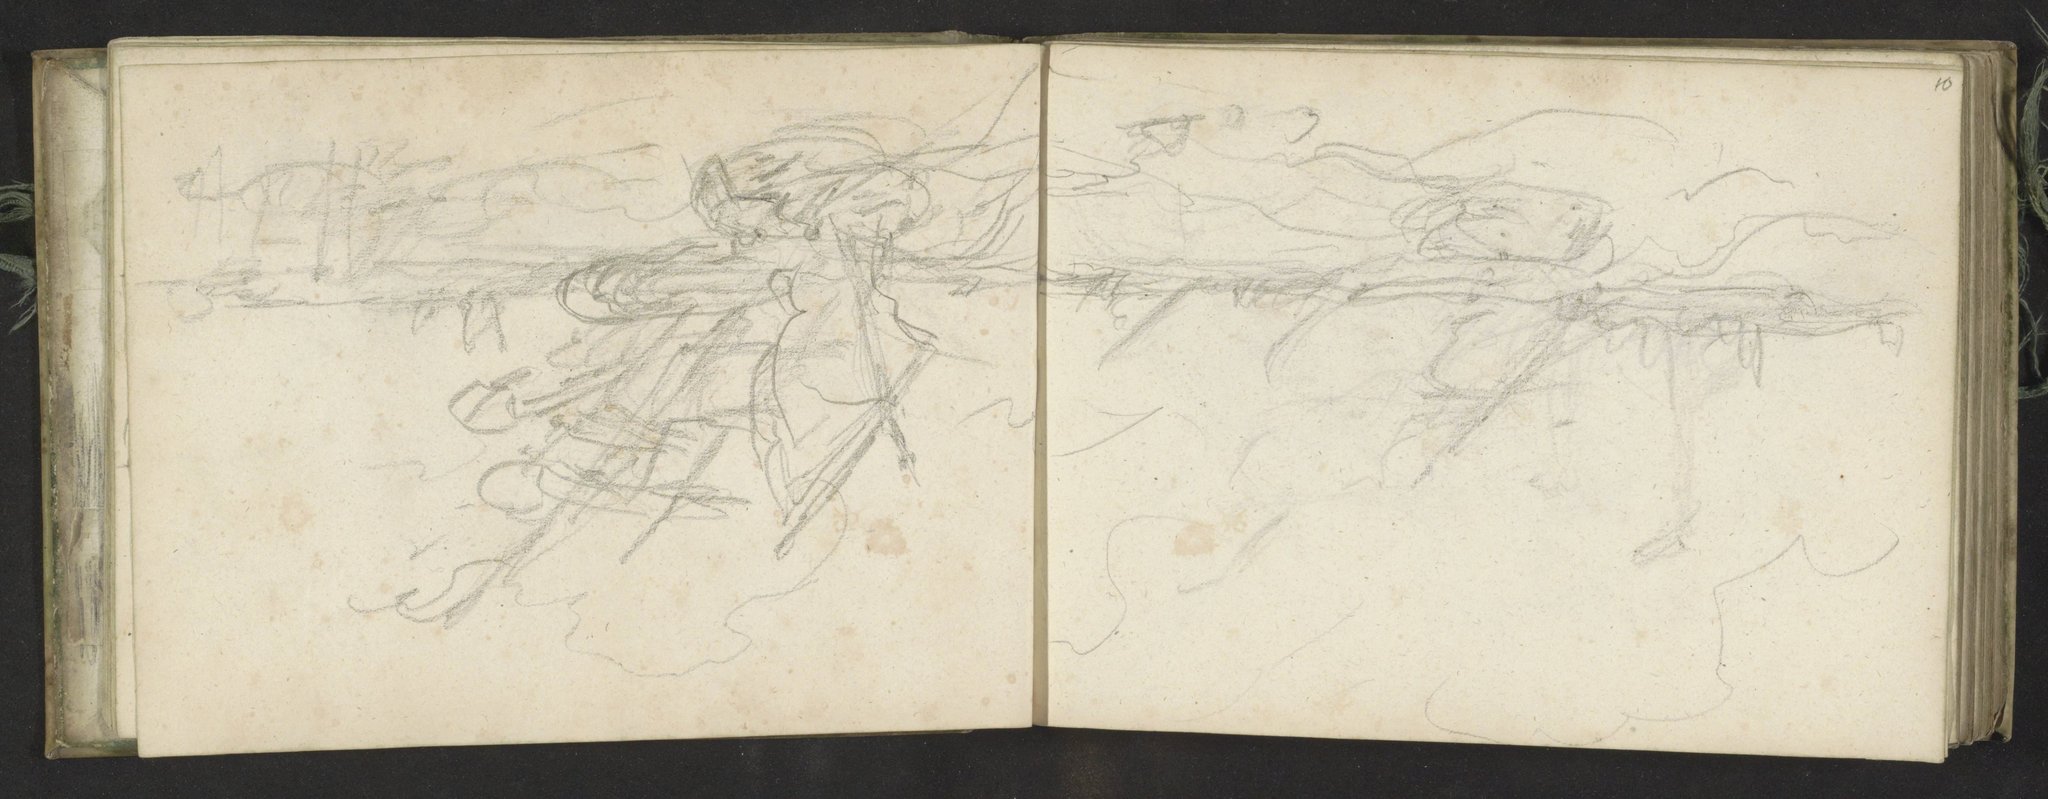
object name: sketchbook leaf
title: Zeilschepen op een woelige zee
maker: martinus schouman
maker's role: draughtsman, painter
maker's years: 1770-1848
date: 1780-1848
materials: paper, pencil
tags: sailing-ship, sailing-boat, storm at sea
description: Blad 9 verso en 10 recto uit een schetsboek met 53 bladen.